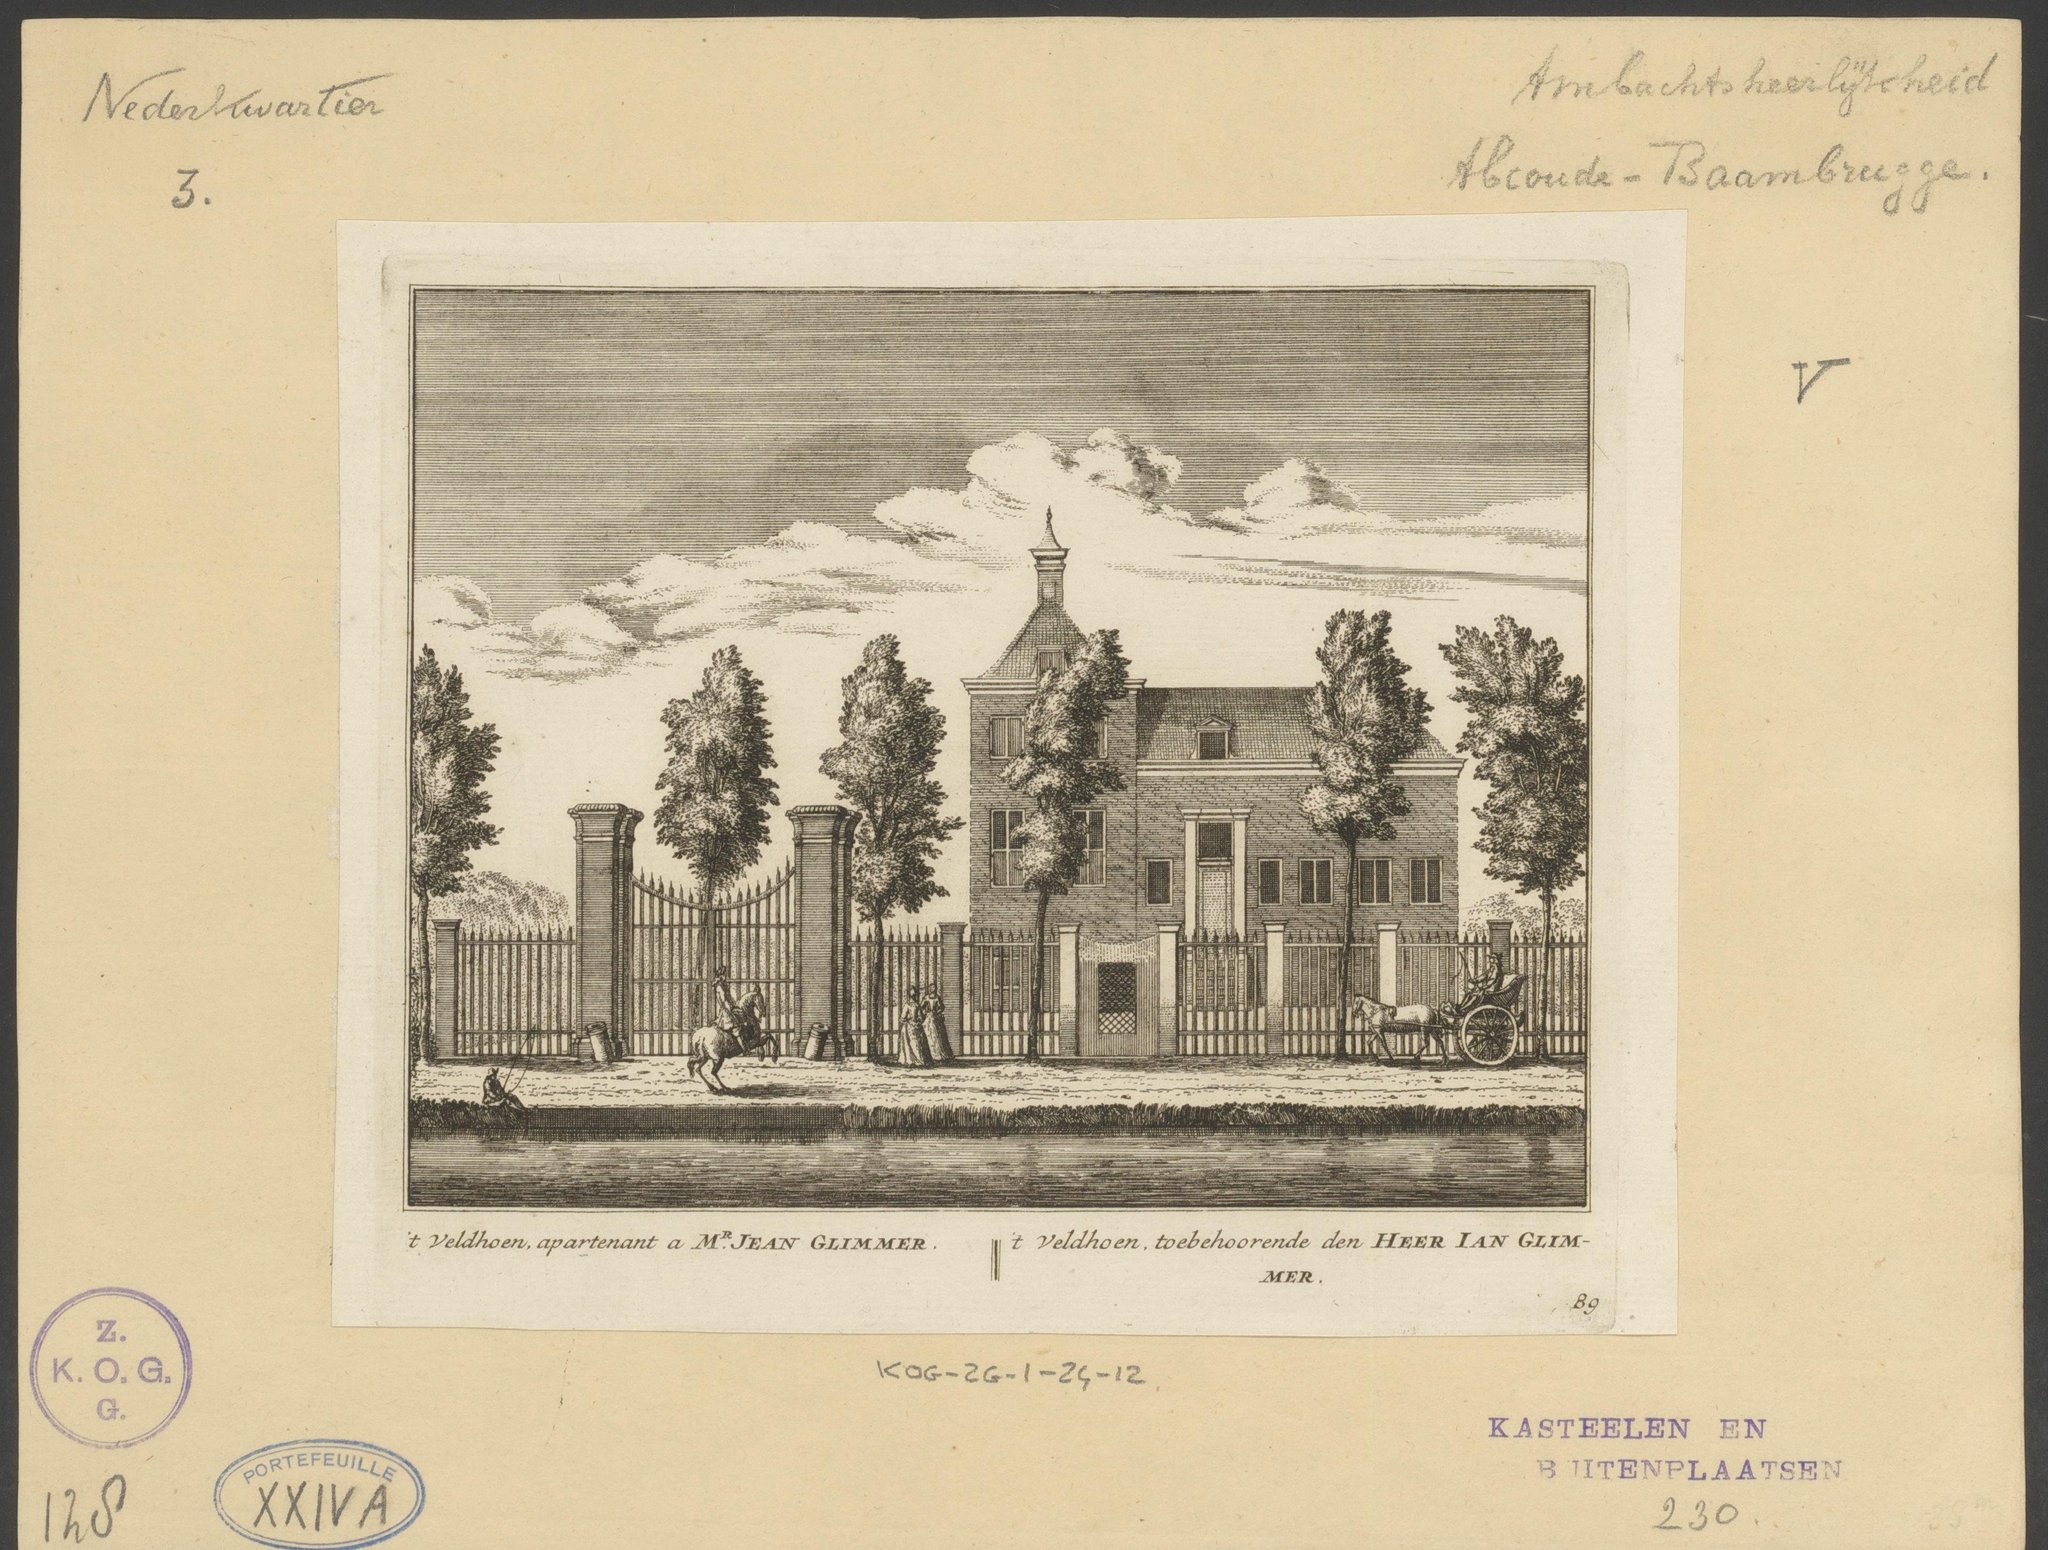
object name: book illustration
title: 't Veldhoen, apartenent a mr. Jean Glimmer / 't Veldhoen, toebehoorende den heer Jan Glimmer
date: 1730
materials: paper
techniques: etching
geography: amsterdam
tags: rural housing, e.g. country-house, villa, cottage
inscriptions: collector's mark: Lugt 1641, stamp, stamp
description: Rechtsonder genummerd: 89. Onderwerpsrubrieken binnen de Atlas Zeden en Gewoonten: Zeden en Gewoonten in Engeren Zin, De Woning. Kastelen en buitenplaatsen. Utrecht (vervolg.).